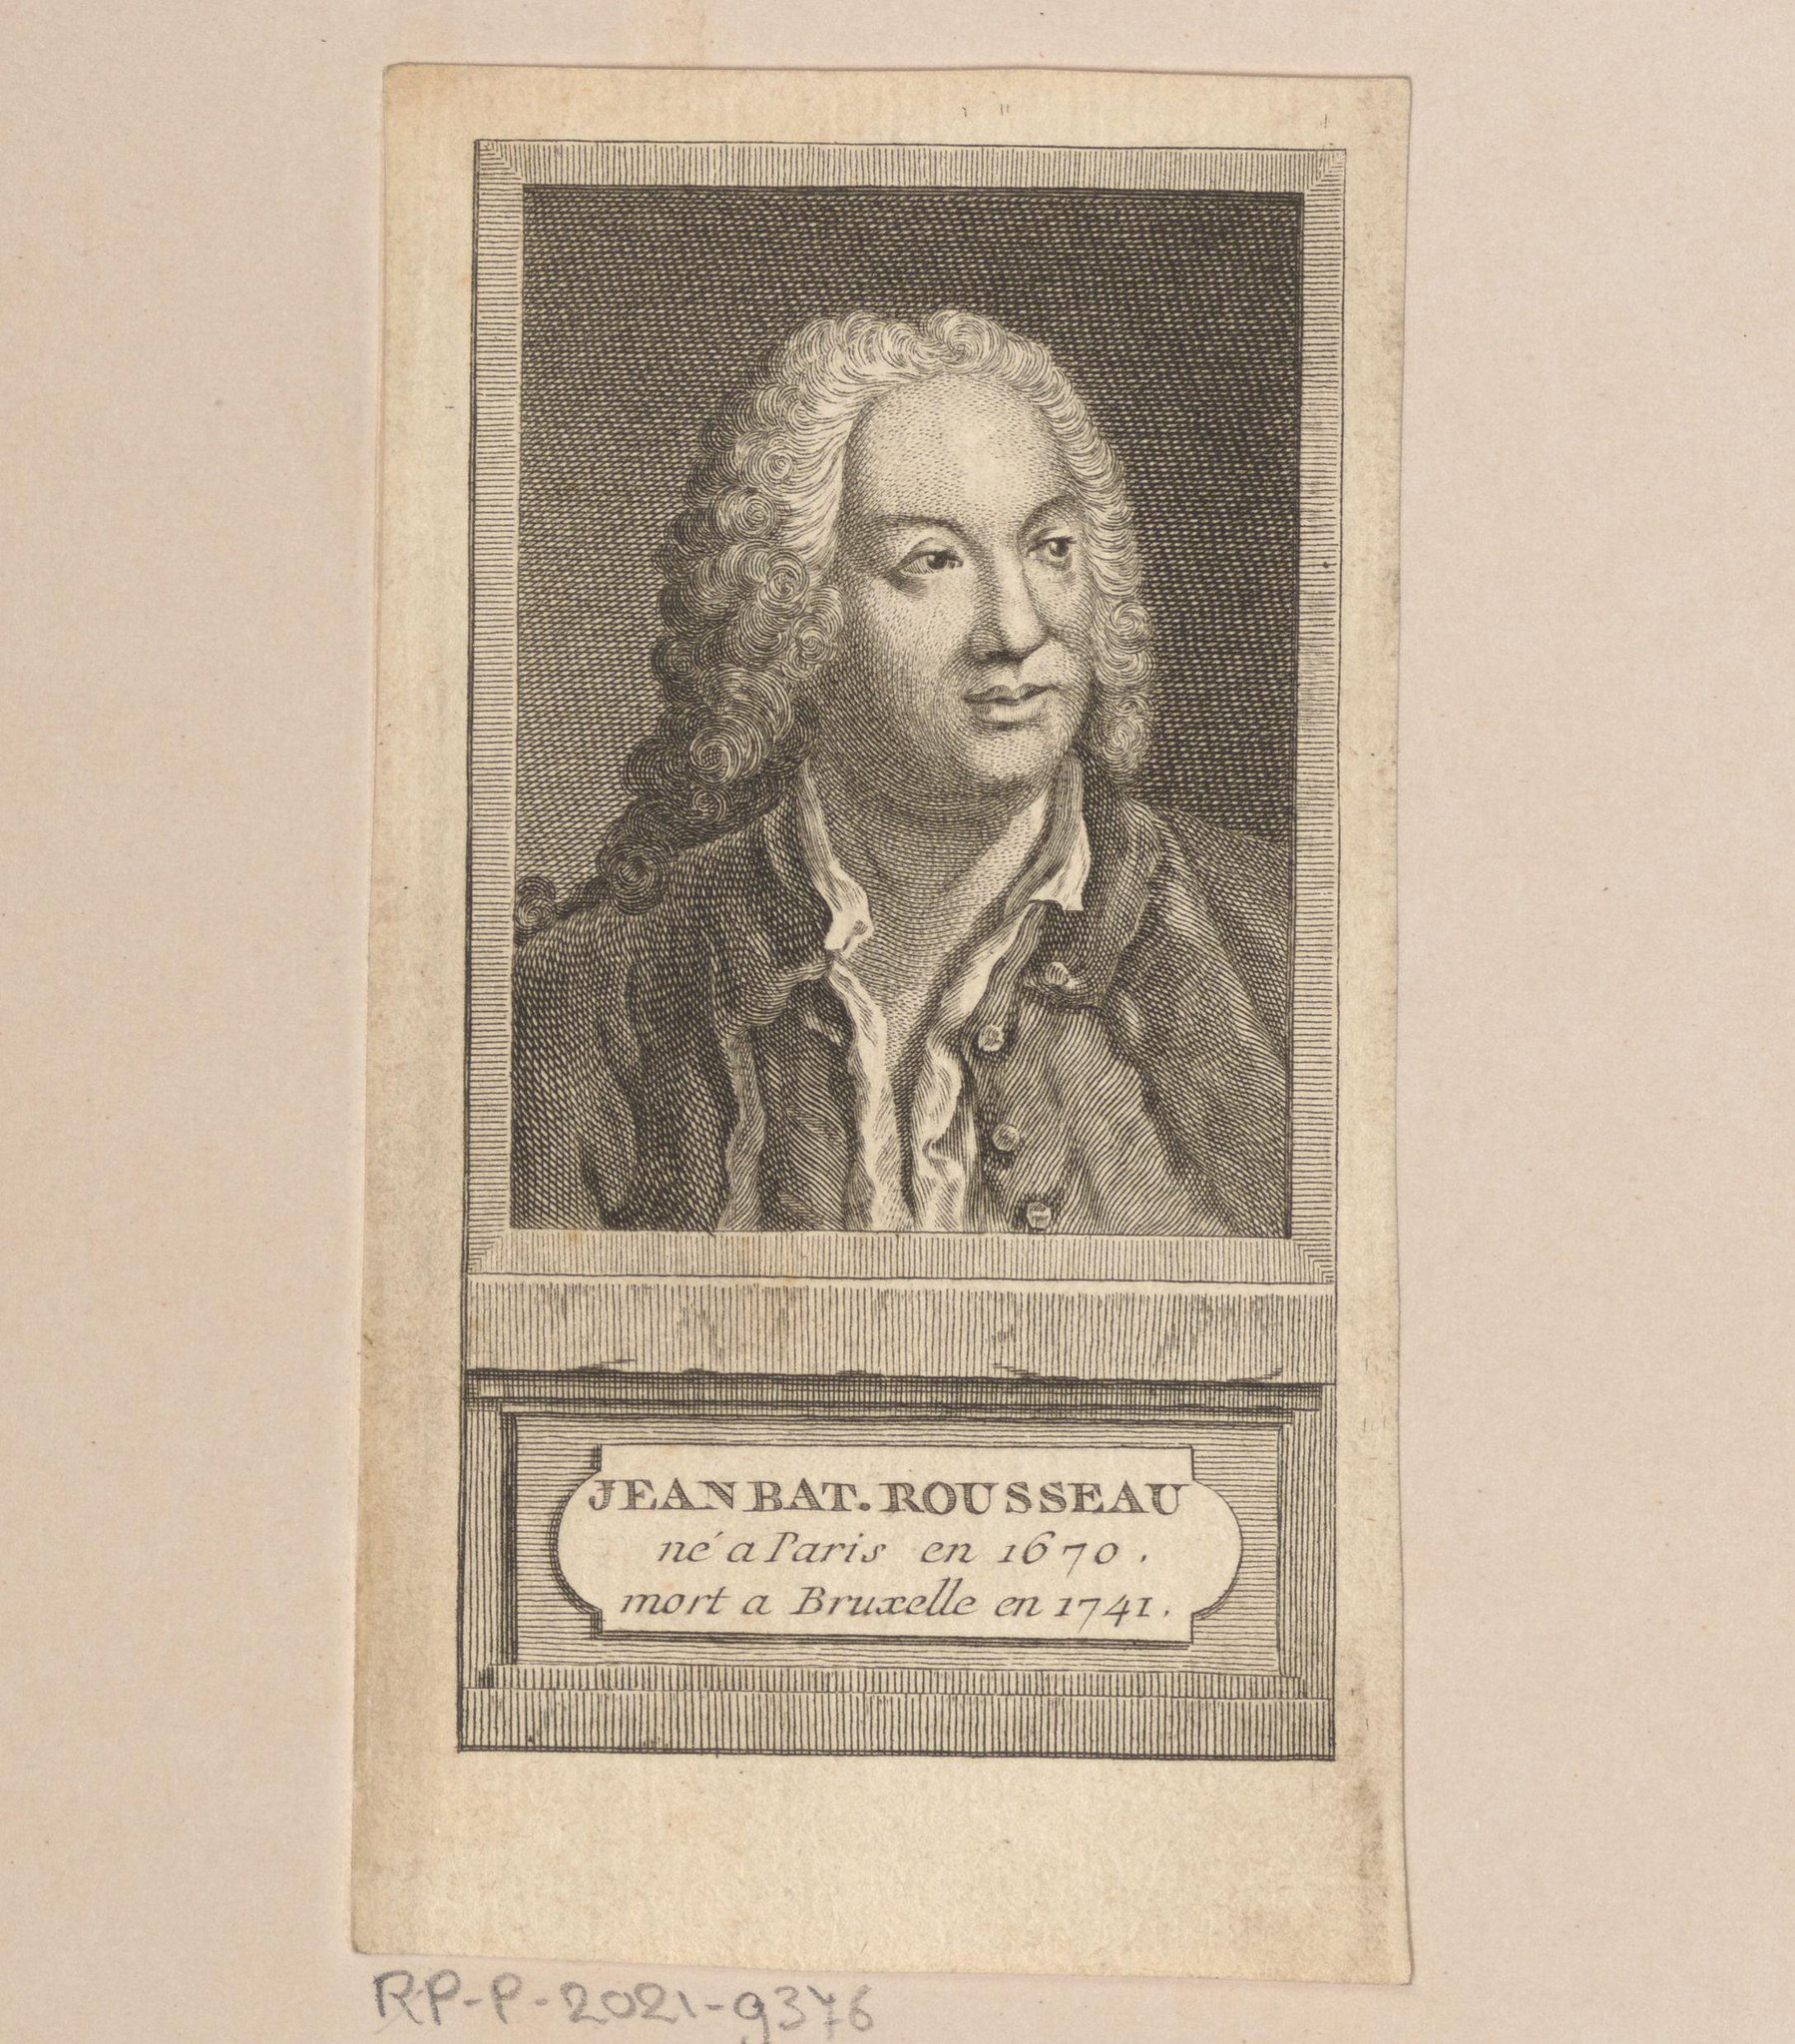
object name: print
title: Portret van Jean Baptiste Rousseau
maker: Anonymous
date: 1741-1799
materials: paper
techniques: engraving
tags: paris, brussels, jean baptiste rousseau (1669-1741), historical persons